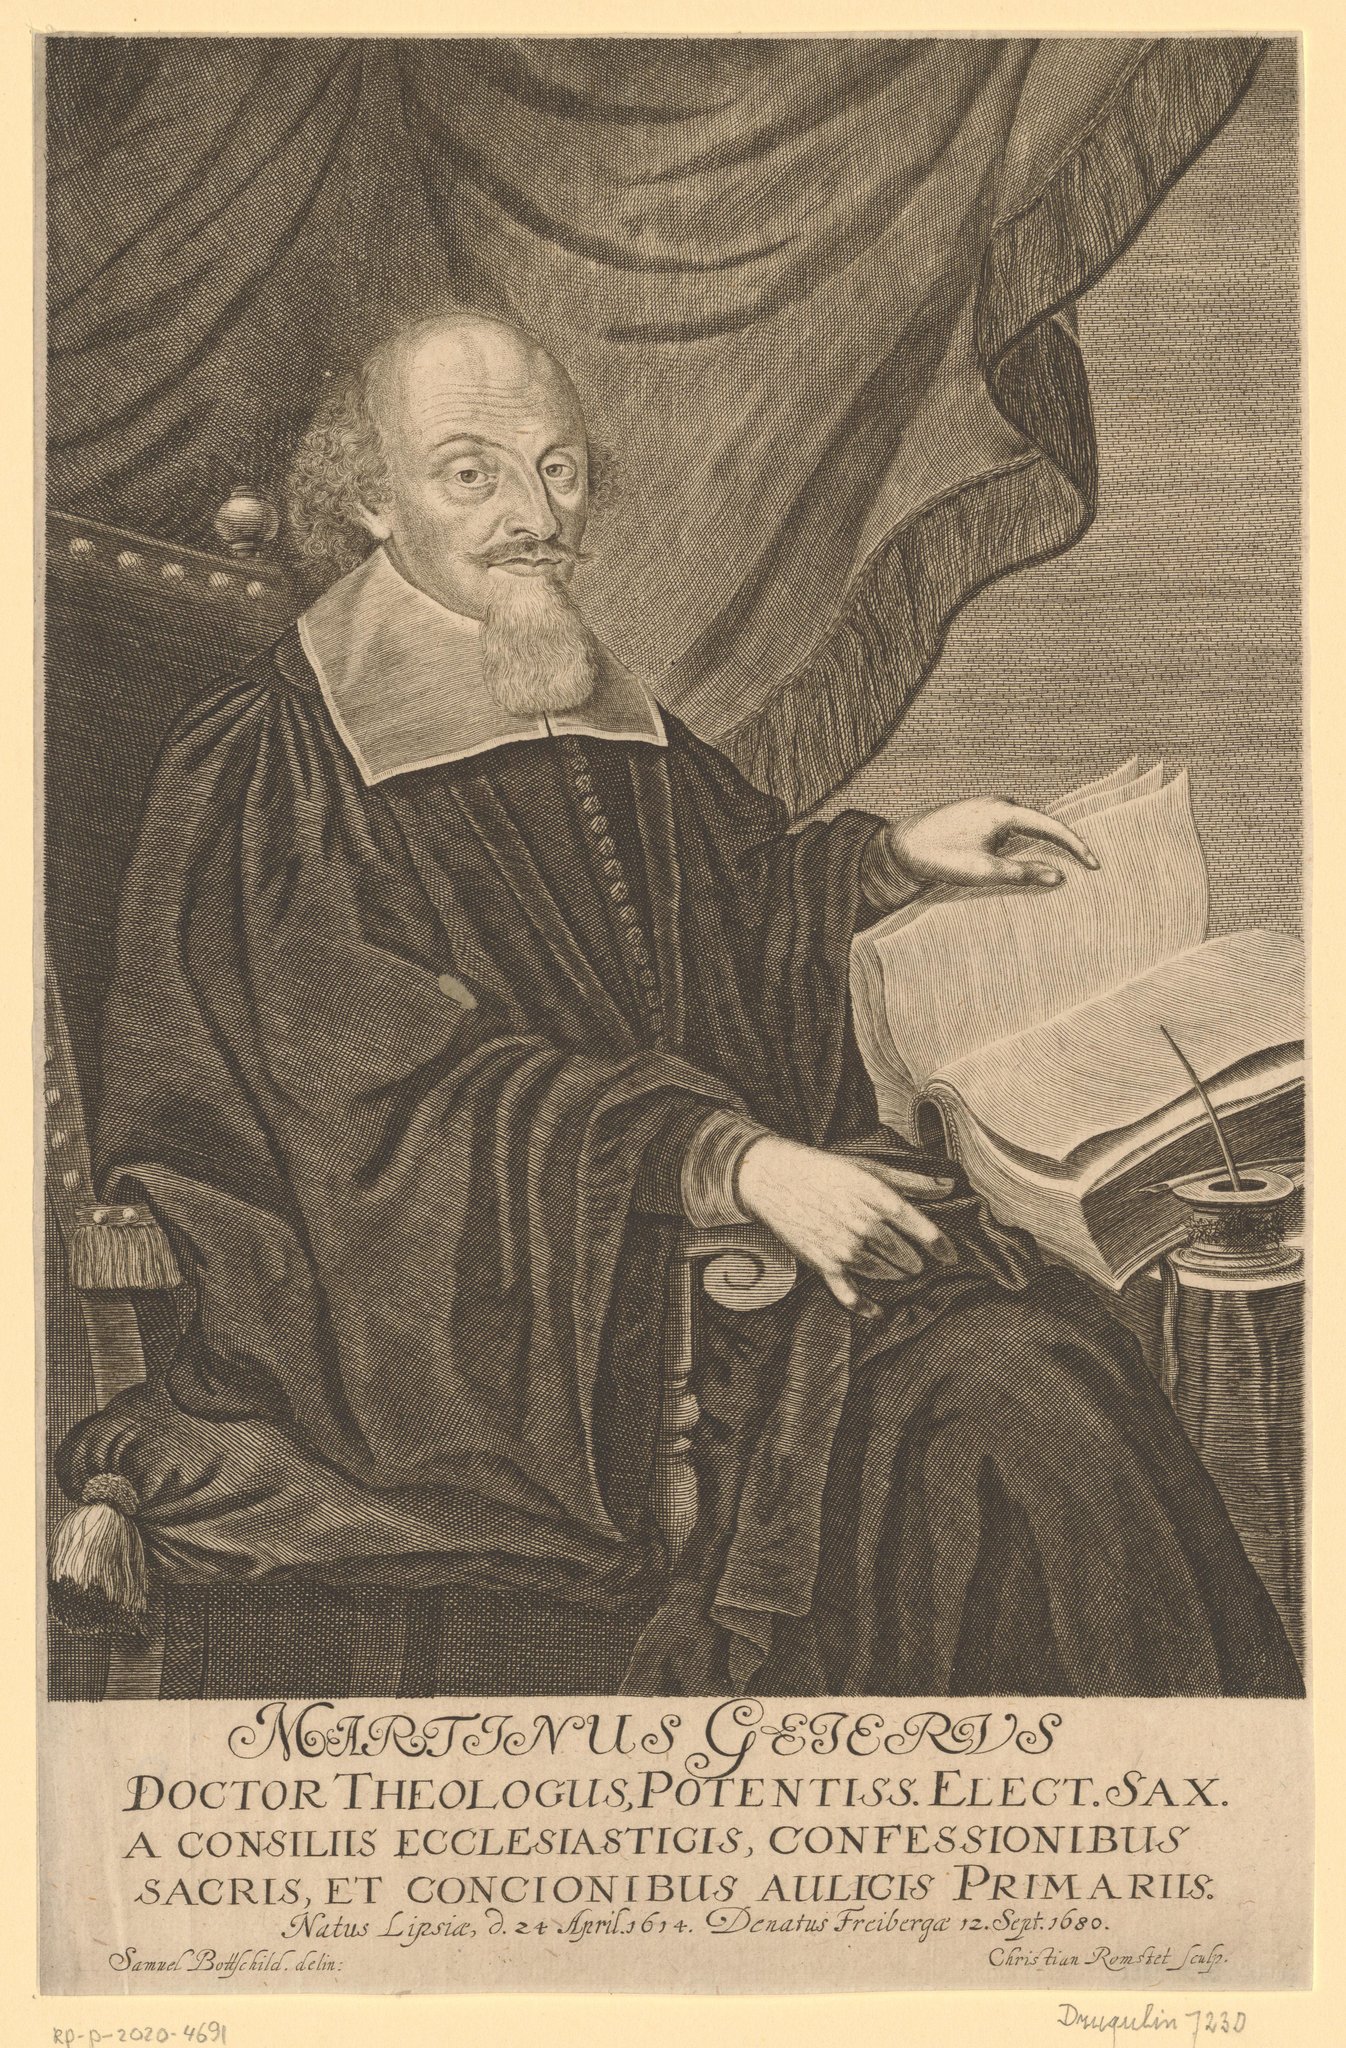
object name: print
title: Portret van Martin Geier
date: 1680-1721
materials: paper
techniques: engraving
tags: theologian, historical persons, writer, poet, author